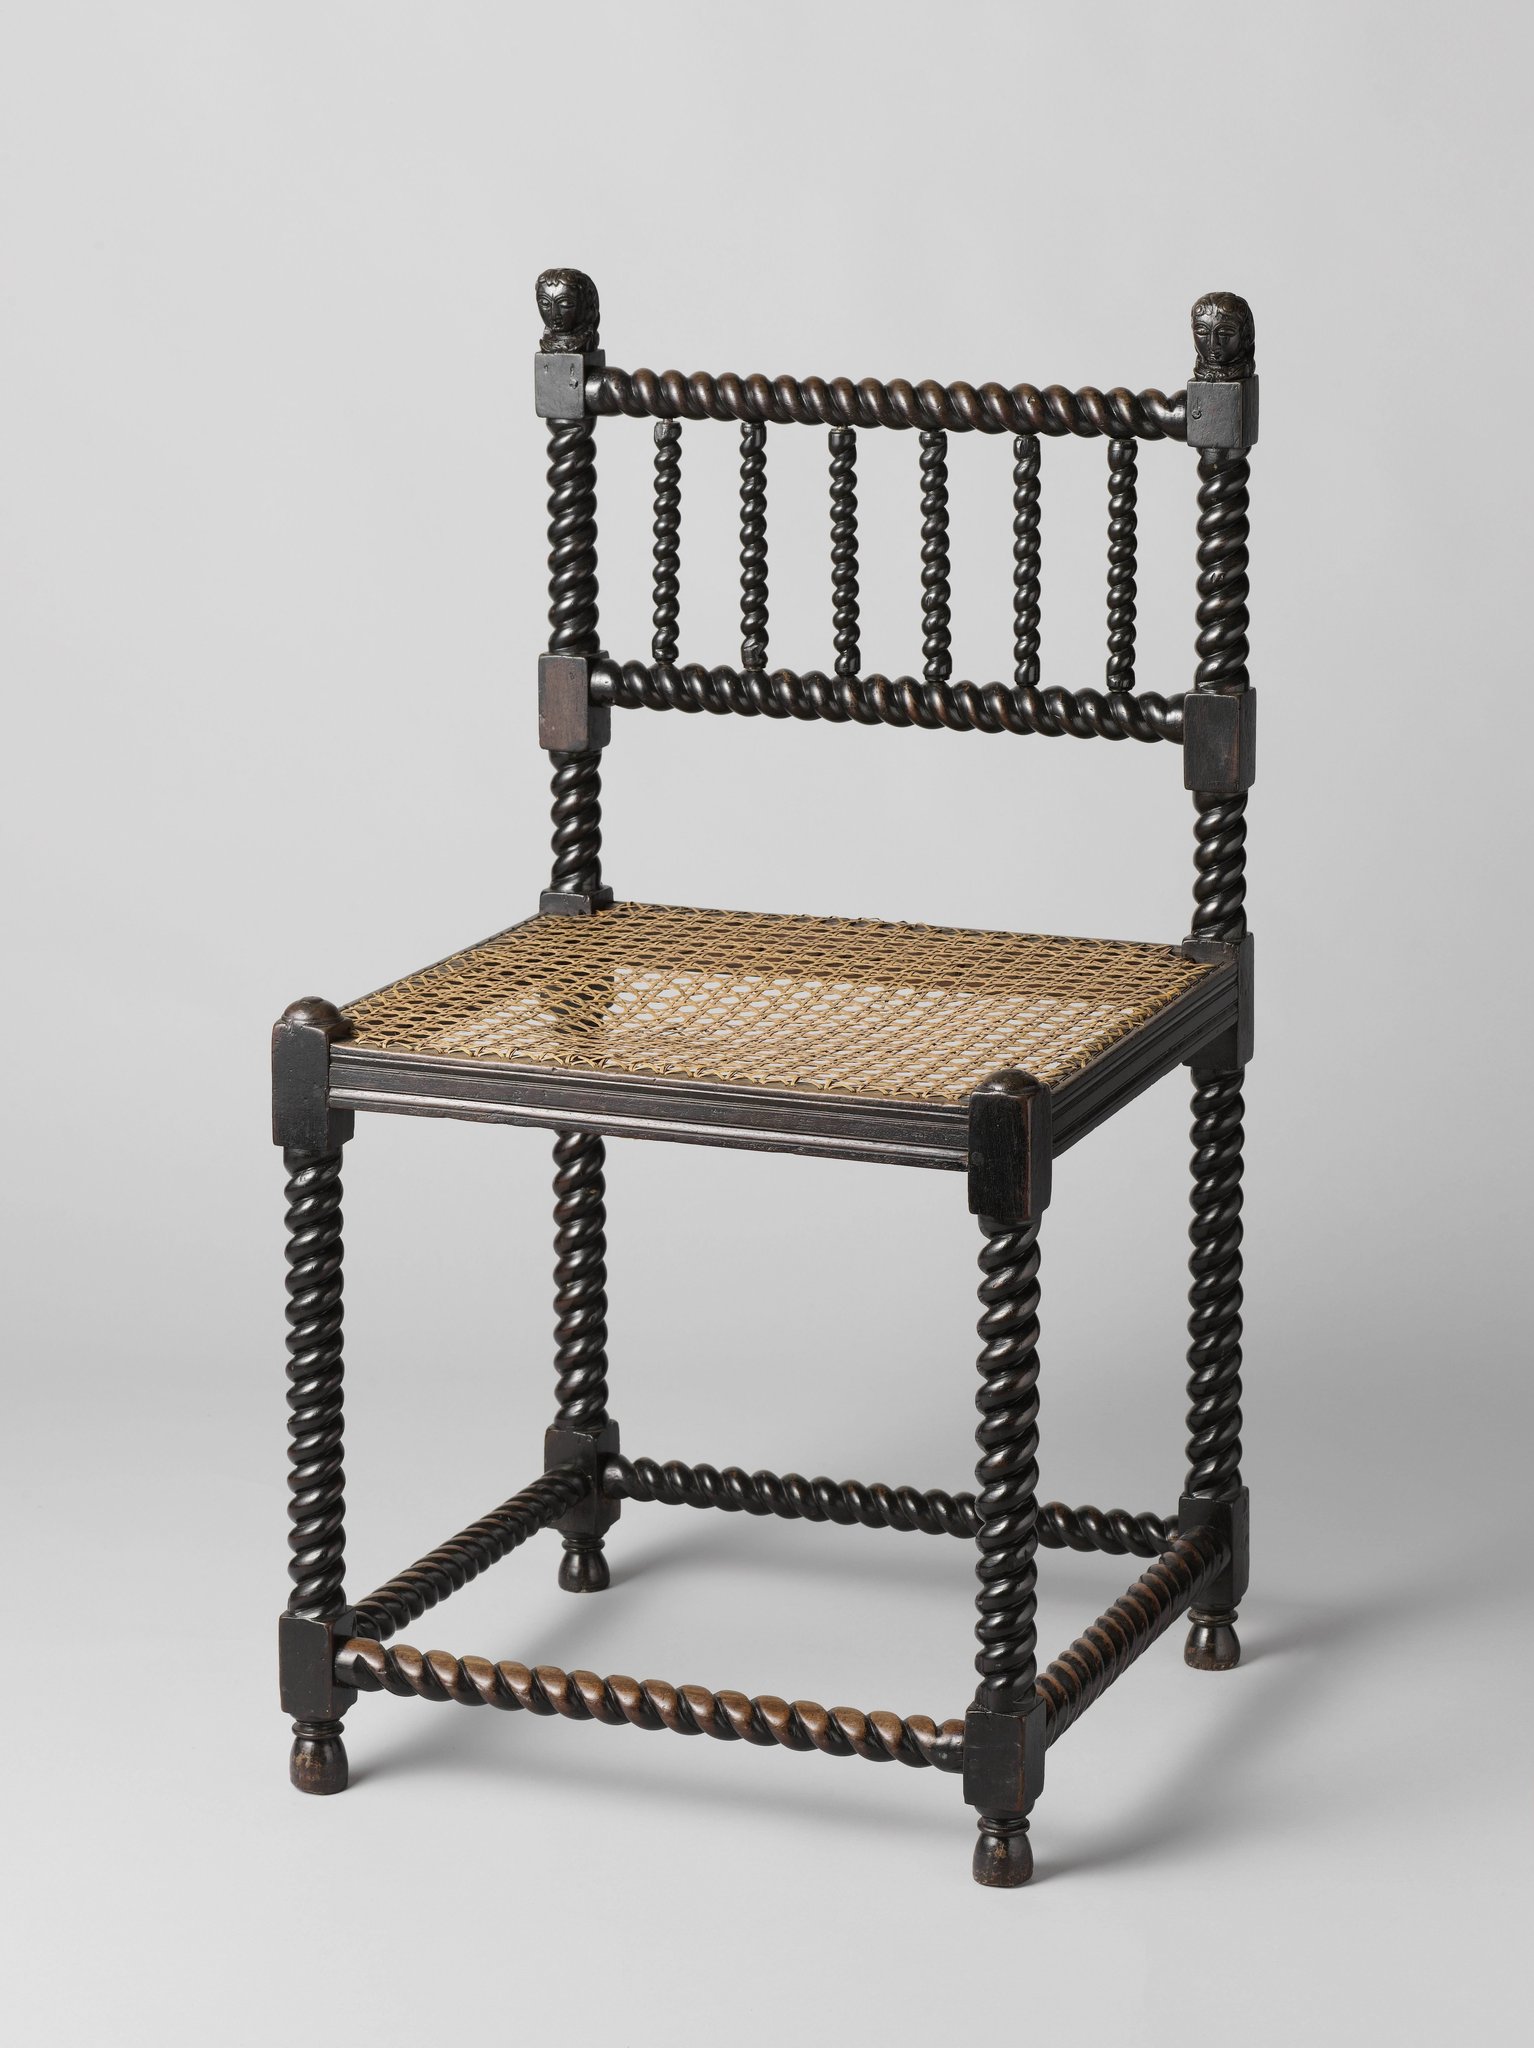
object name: seating furniture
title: Stoel met geslingerde poten, rugstijlen bekroond door gesneden koppen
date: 1650-1675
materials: wood, rattan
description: Chair. Ebony, cane. Indonesia, 1650 - 1700.